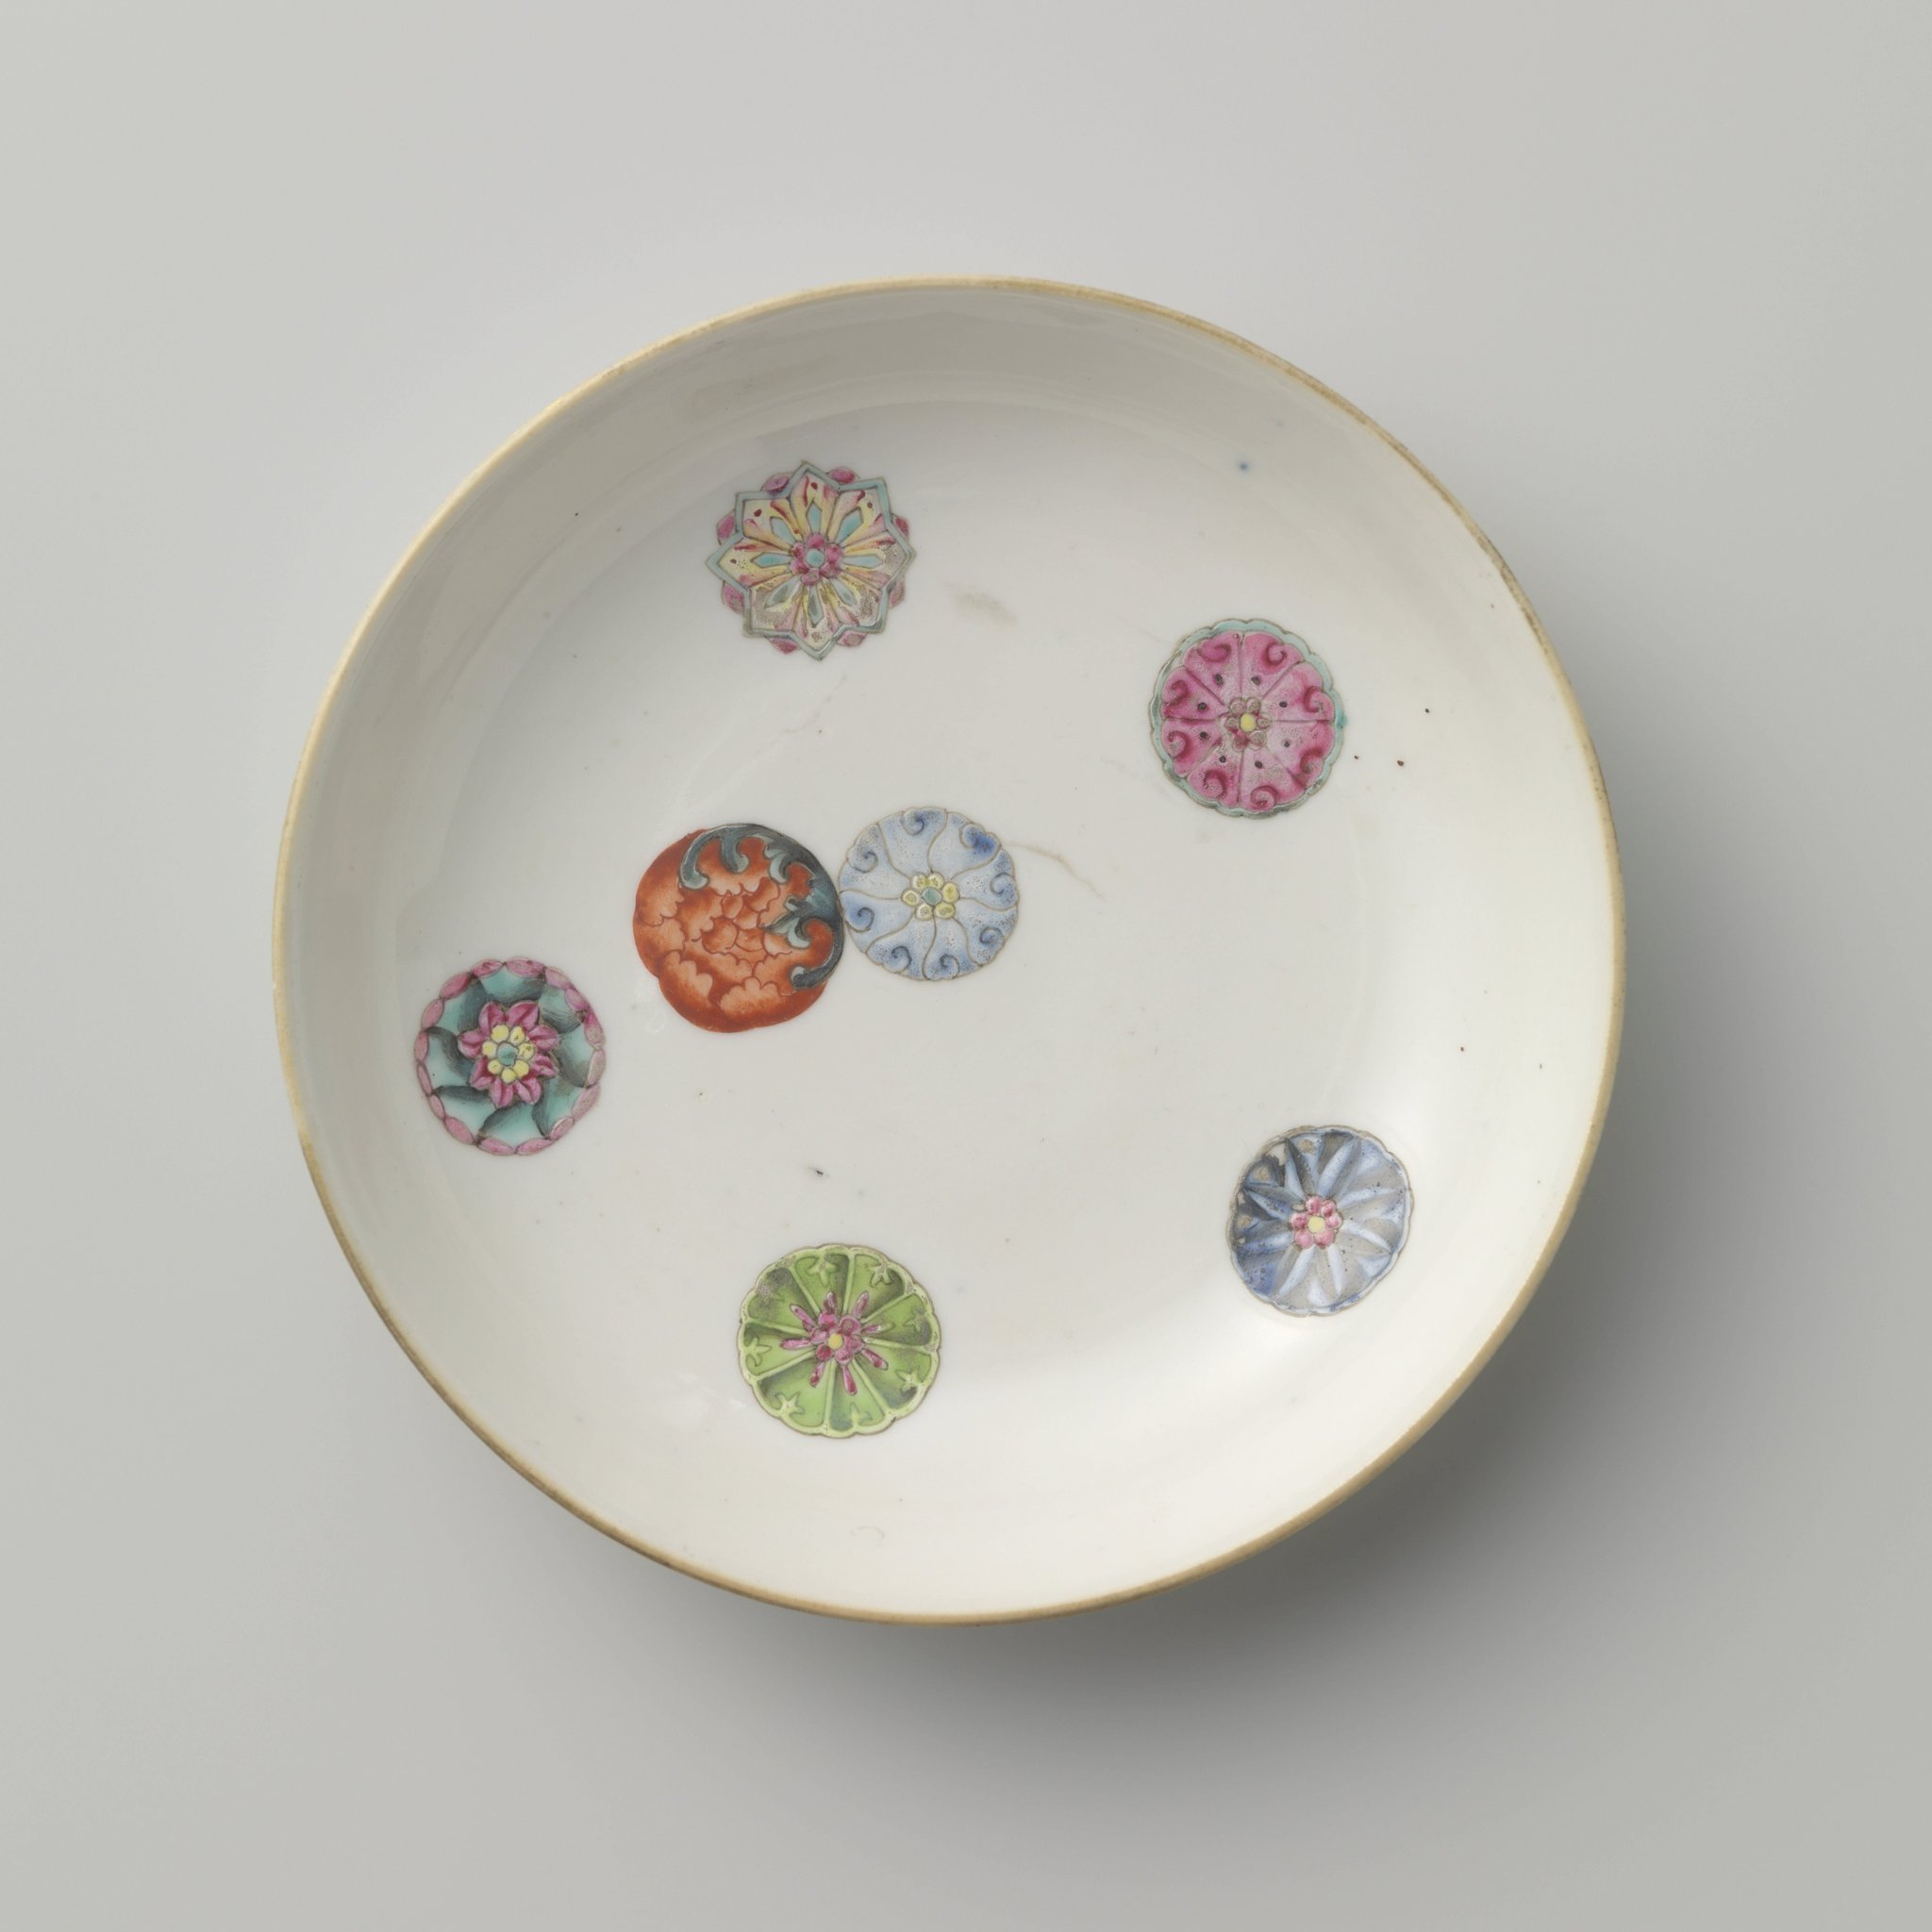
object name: kop en schotel, kop en schotel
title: Saucer with scattered stylised flowers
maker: Anonymous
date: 1840-1860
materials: glaze, paint, porcelain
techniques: firing, turning, vitrification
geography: china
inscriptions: mark: ‘大 清 乾 隆 年 製’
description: Schotel van porselein met rechte wand, beschilderd op het glazuur in blauw, rood, roze, groen, geel en zwart. Op de voorzijde van de schotel zeven losse, gestileerde bloemen. Gemerkt op de onderzijde met het zes-karakter zegelmerk van keizer Qianlong. Famille rose.